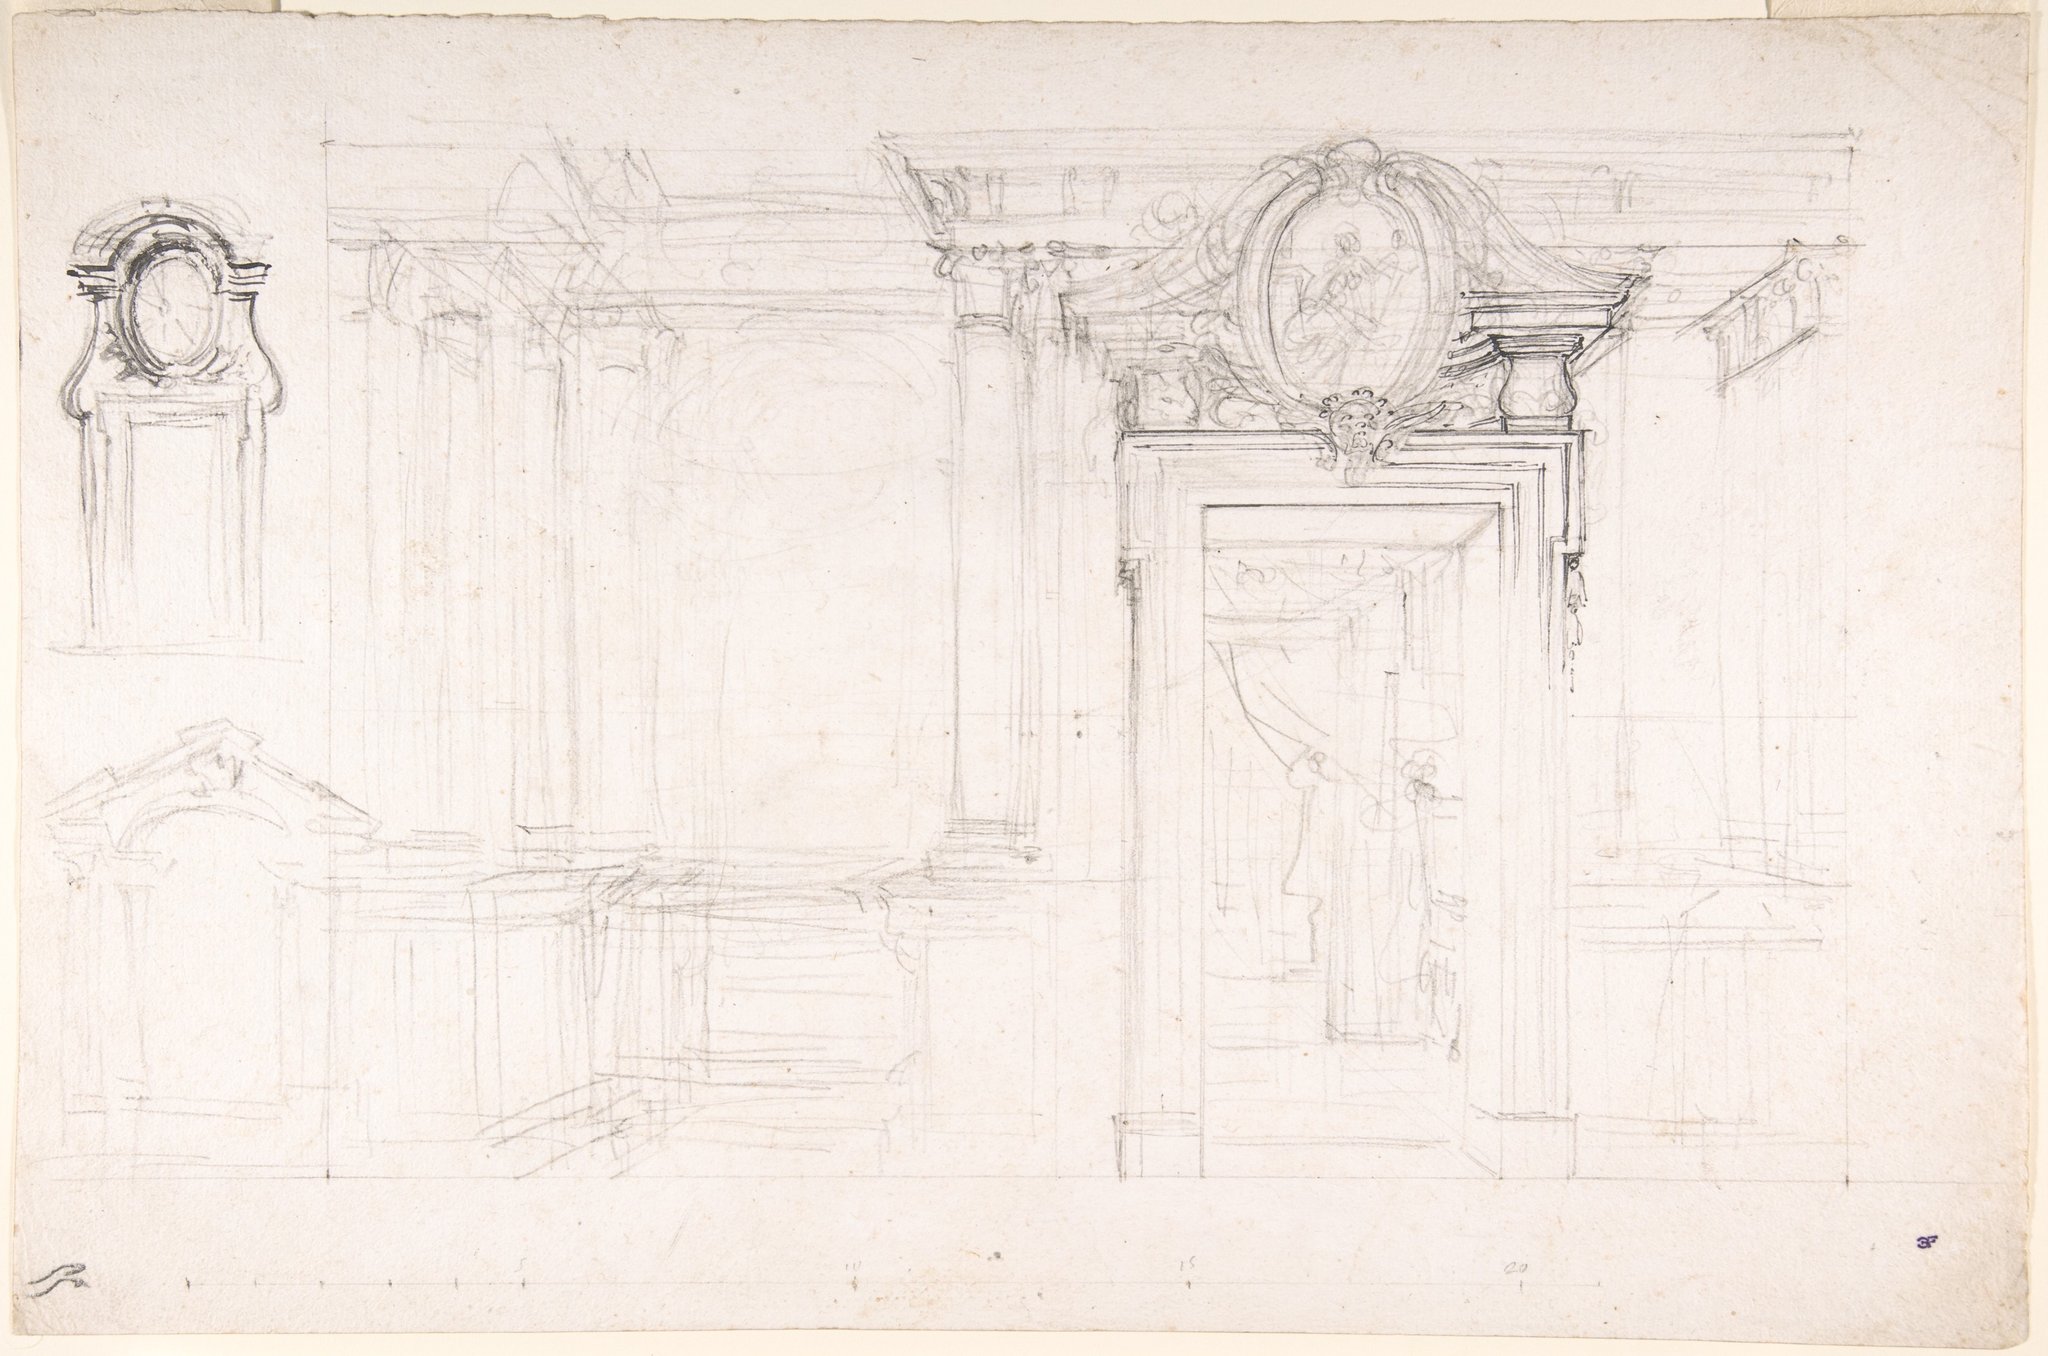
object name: drawing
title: Architectural Sketch for the design of a Wall with Doorway, with two smaller sketches for the design of windows or doorways (recto); Sketches for a plan and partial perspective view of ceiling (verso)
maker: luigi vanvitelli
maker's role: artist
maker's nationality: italian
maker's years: 1700-1773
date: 1700-1773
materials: graphite, ink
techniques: brush, pen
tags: architecture,doorways